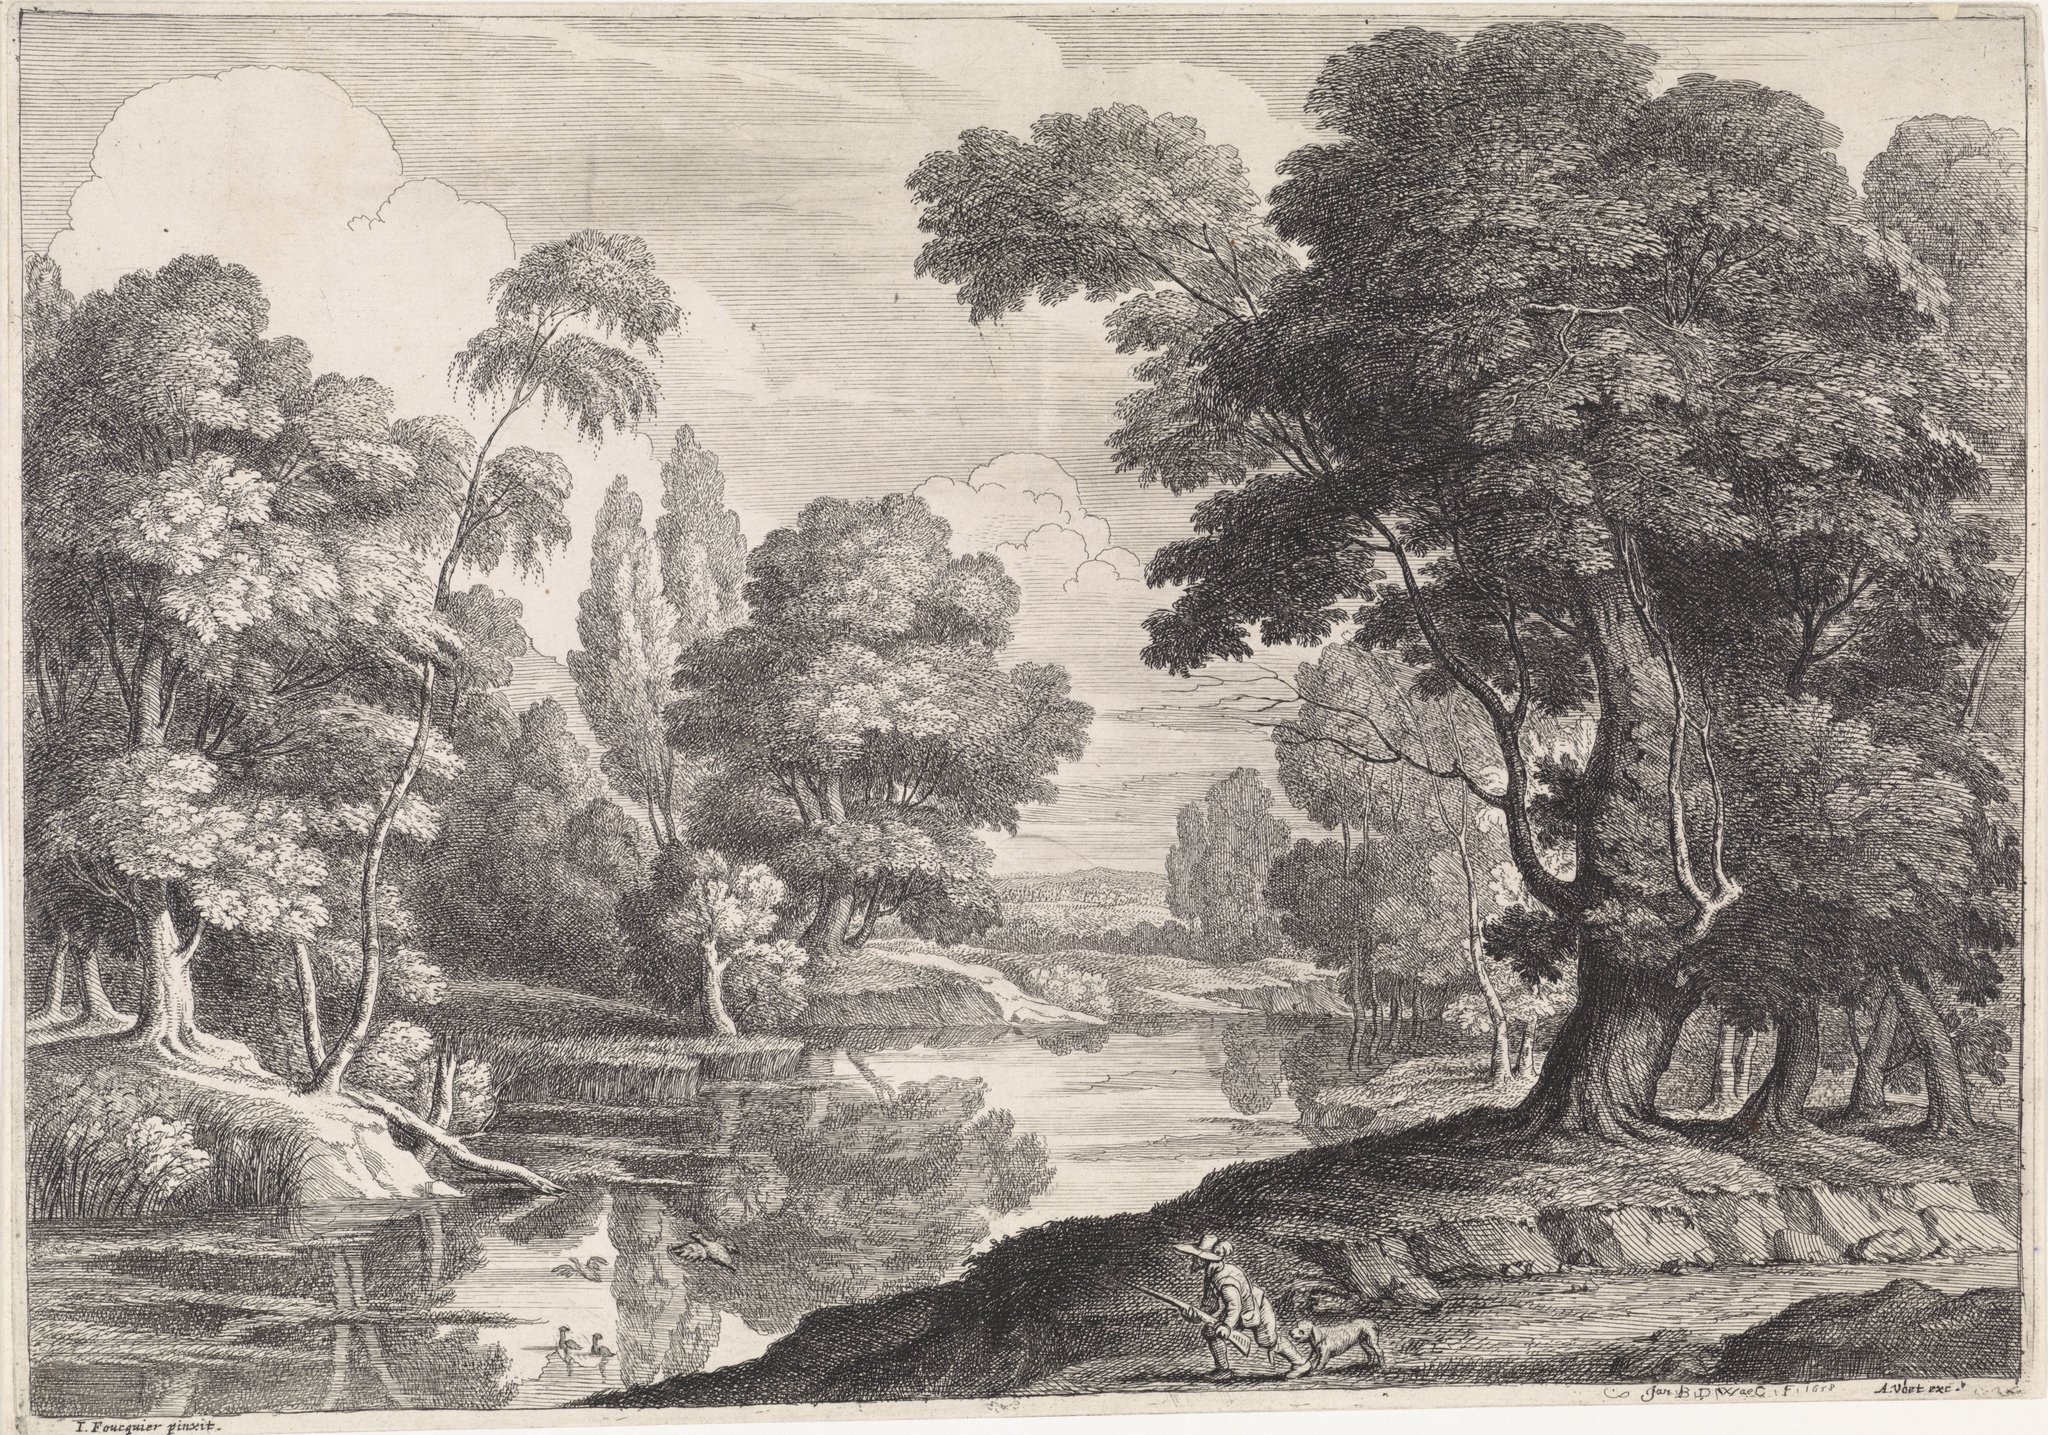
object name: print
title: Landschap met jager die op eenden jaagt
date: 1658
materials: paper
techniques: engraving, etching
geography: antwerp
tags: hunter, bird hunting, dog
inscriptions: collector's mark: Lugt 2228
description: Op de voorgrond een jager, gevolgd door zijn hond, die naar de rand van het meer sluipt richting de eenden die zich in het water bevinden.